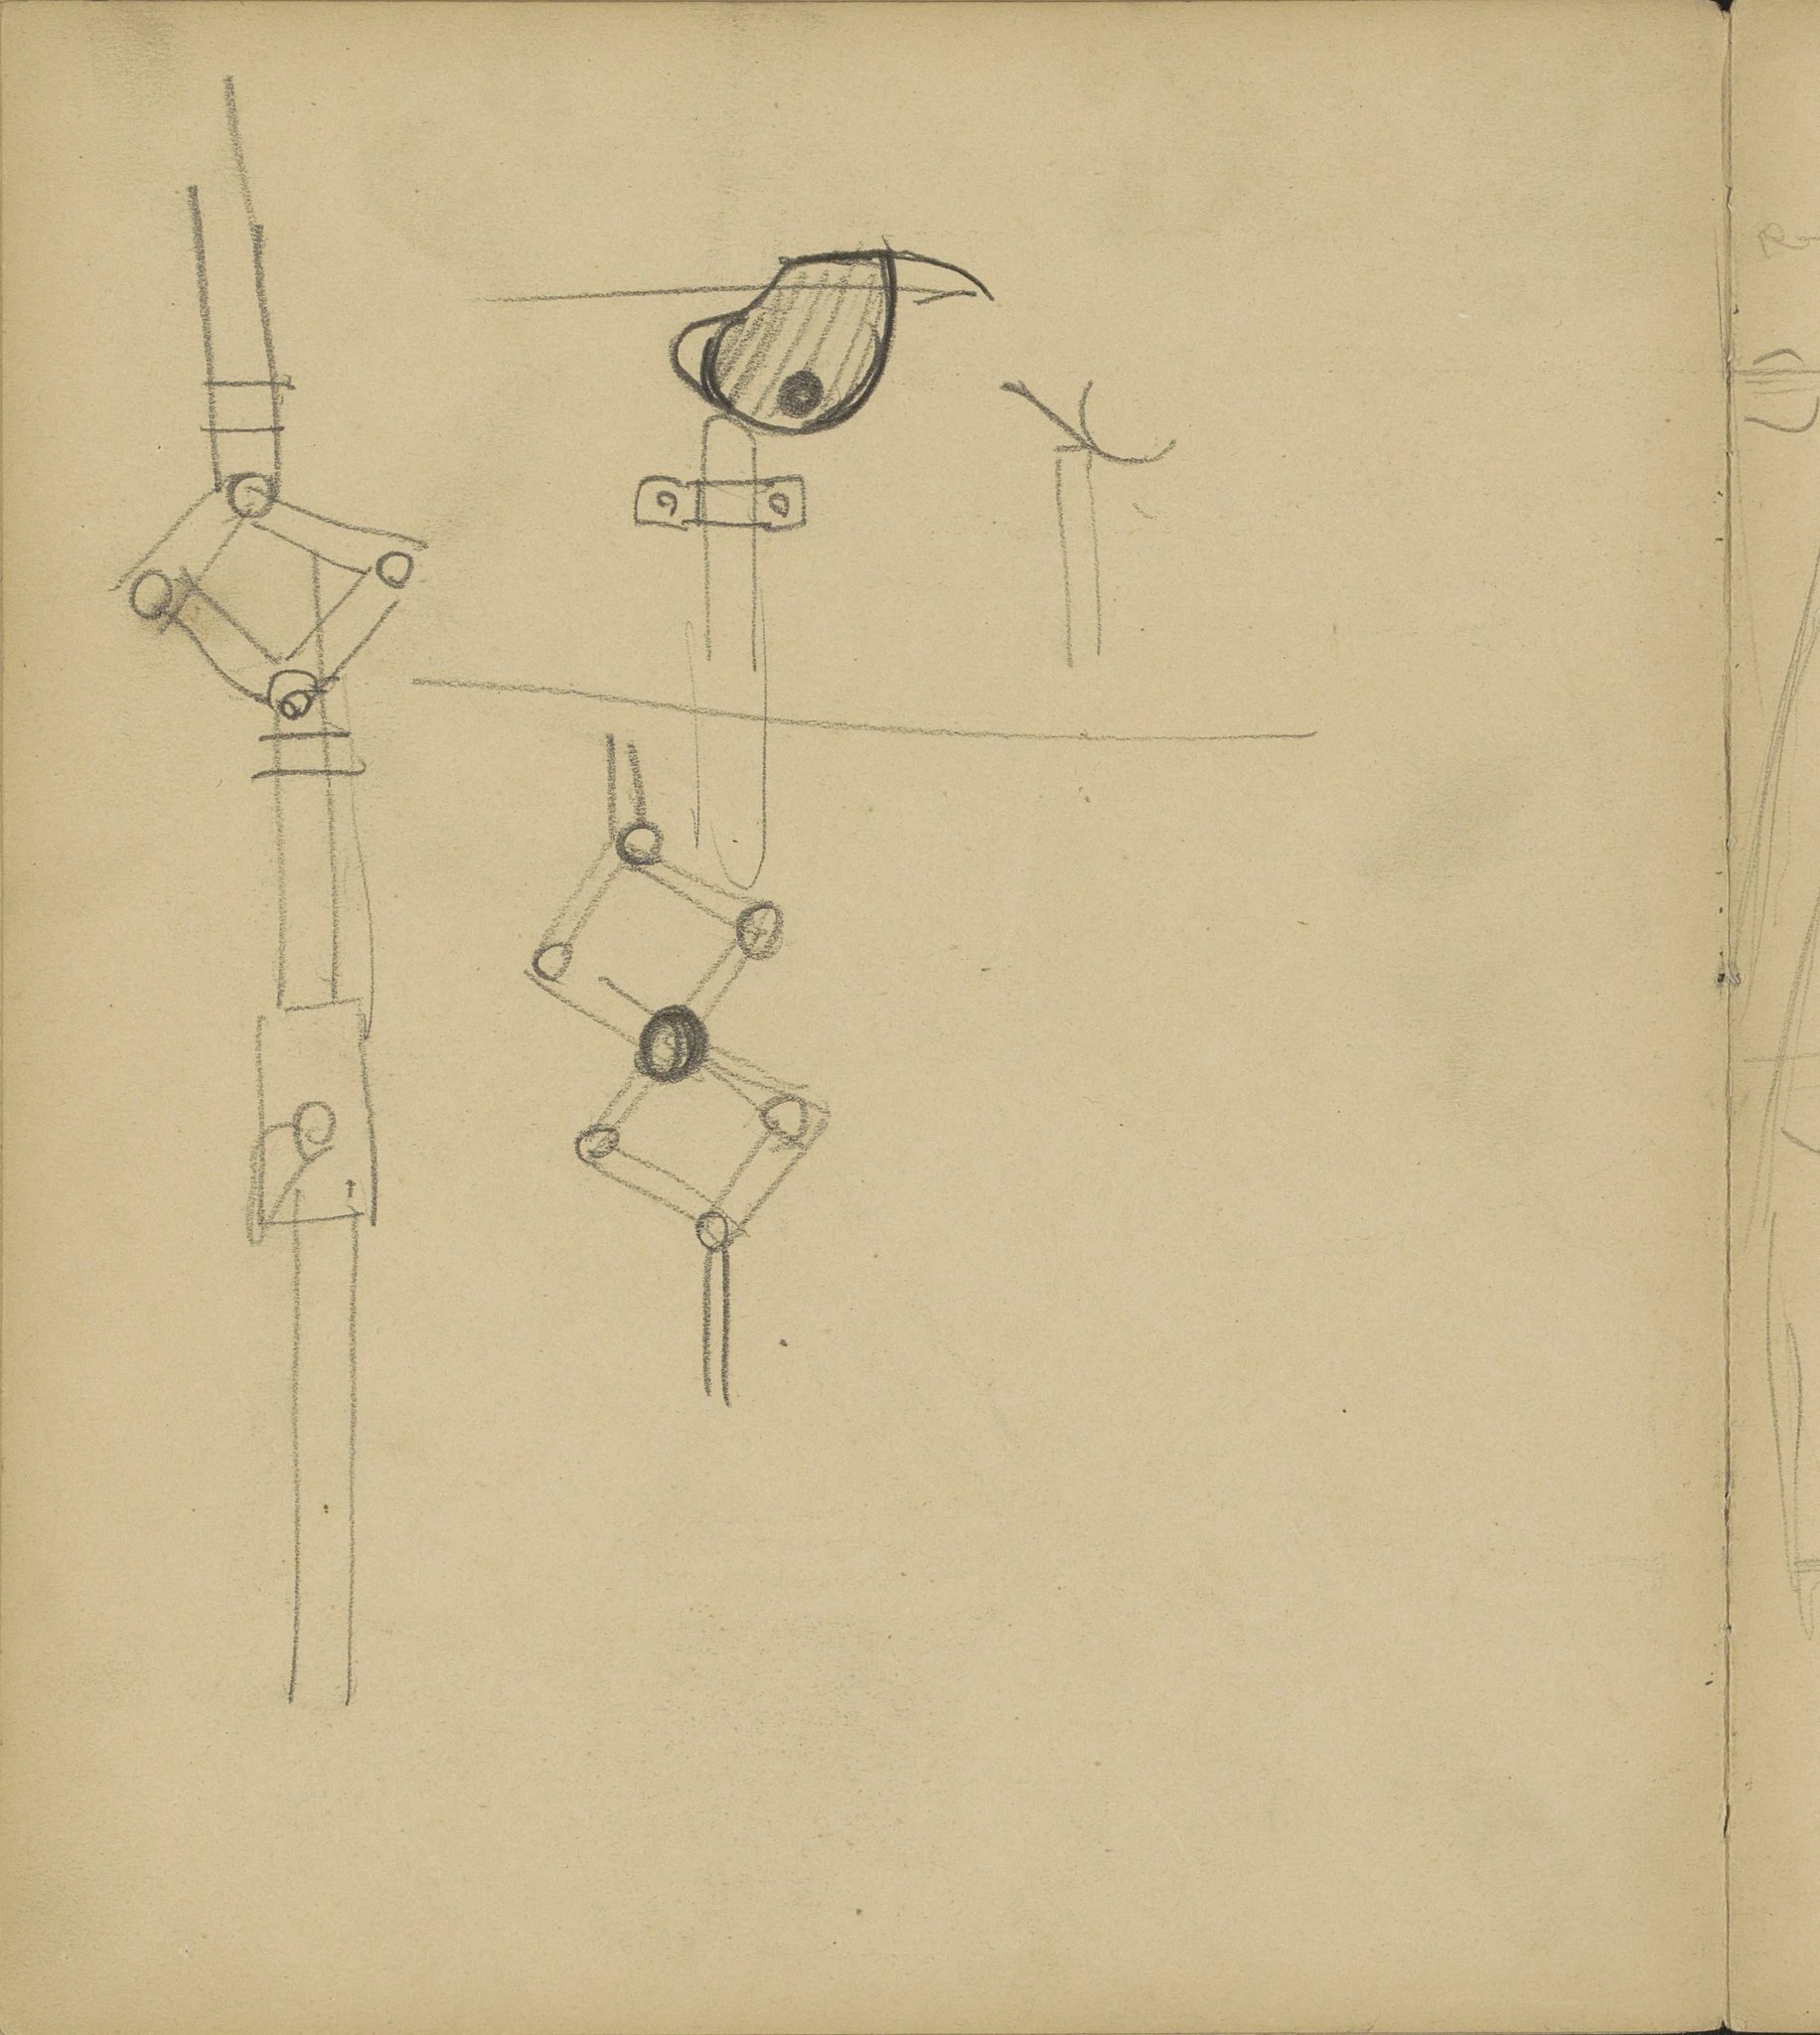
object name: sketchbook leaf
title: Scharnieren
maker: carel adolph lion cachet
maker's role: draughtsman, print maker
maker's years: 1864-1945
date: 1906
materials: paper, pencil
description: Blad 11 verso uit een schetsboek met 27 bladen.